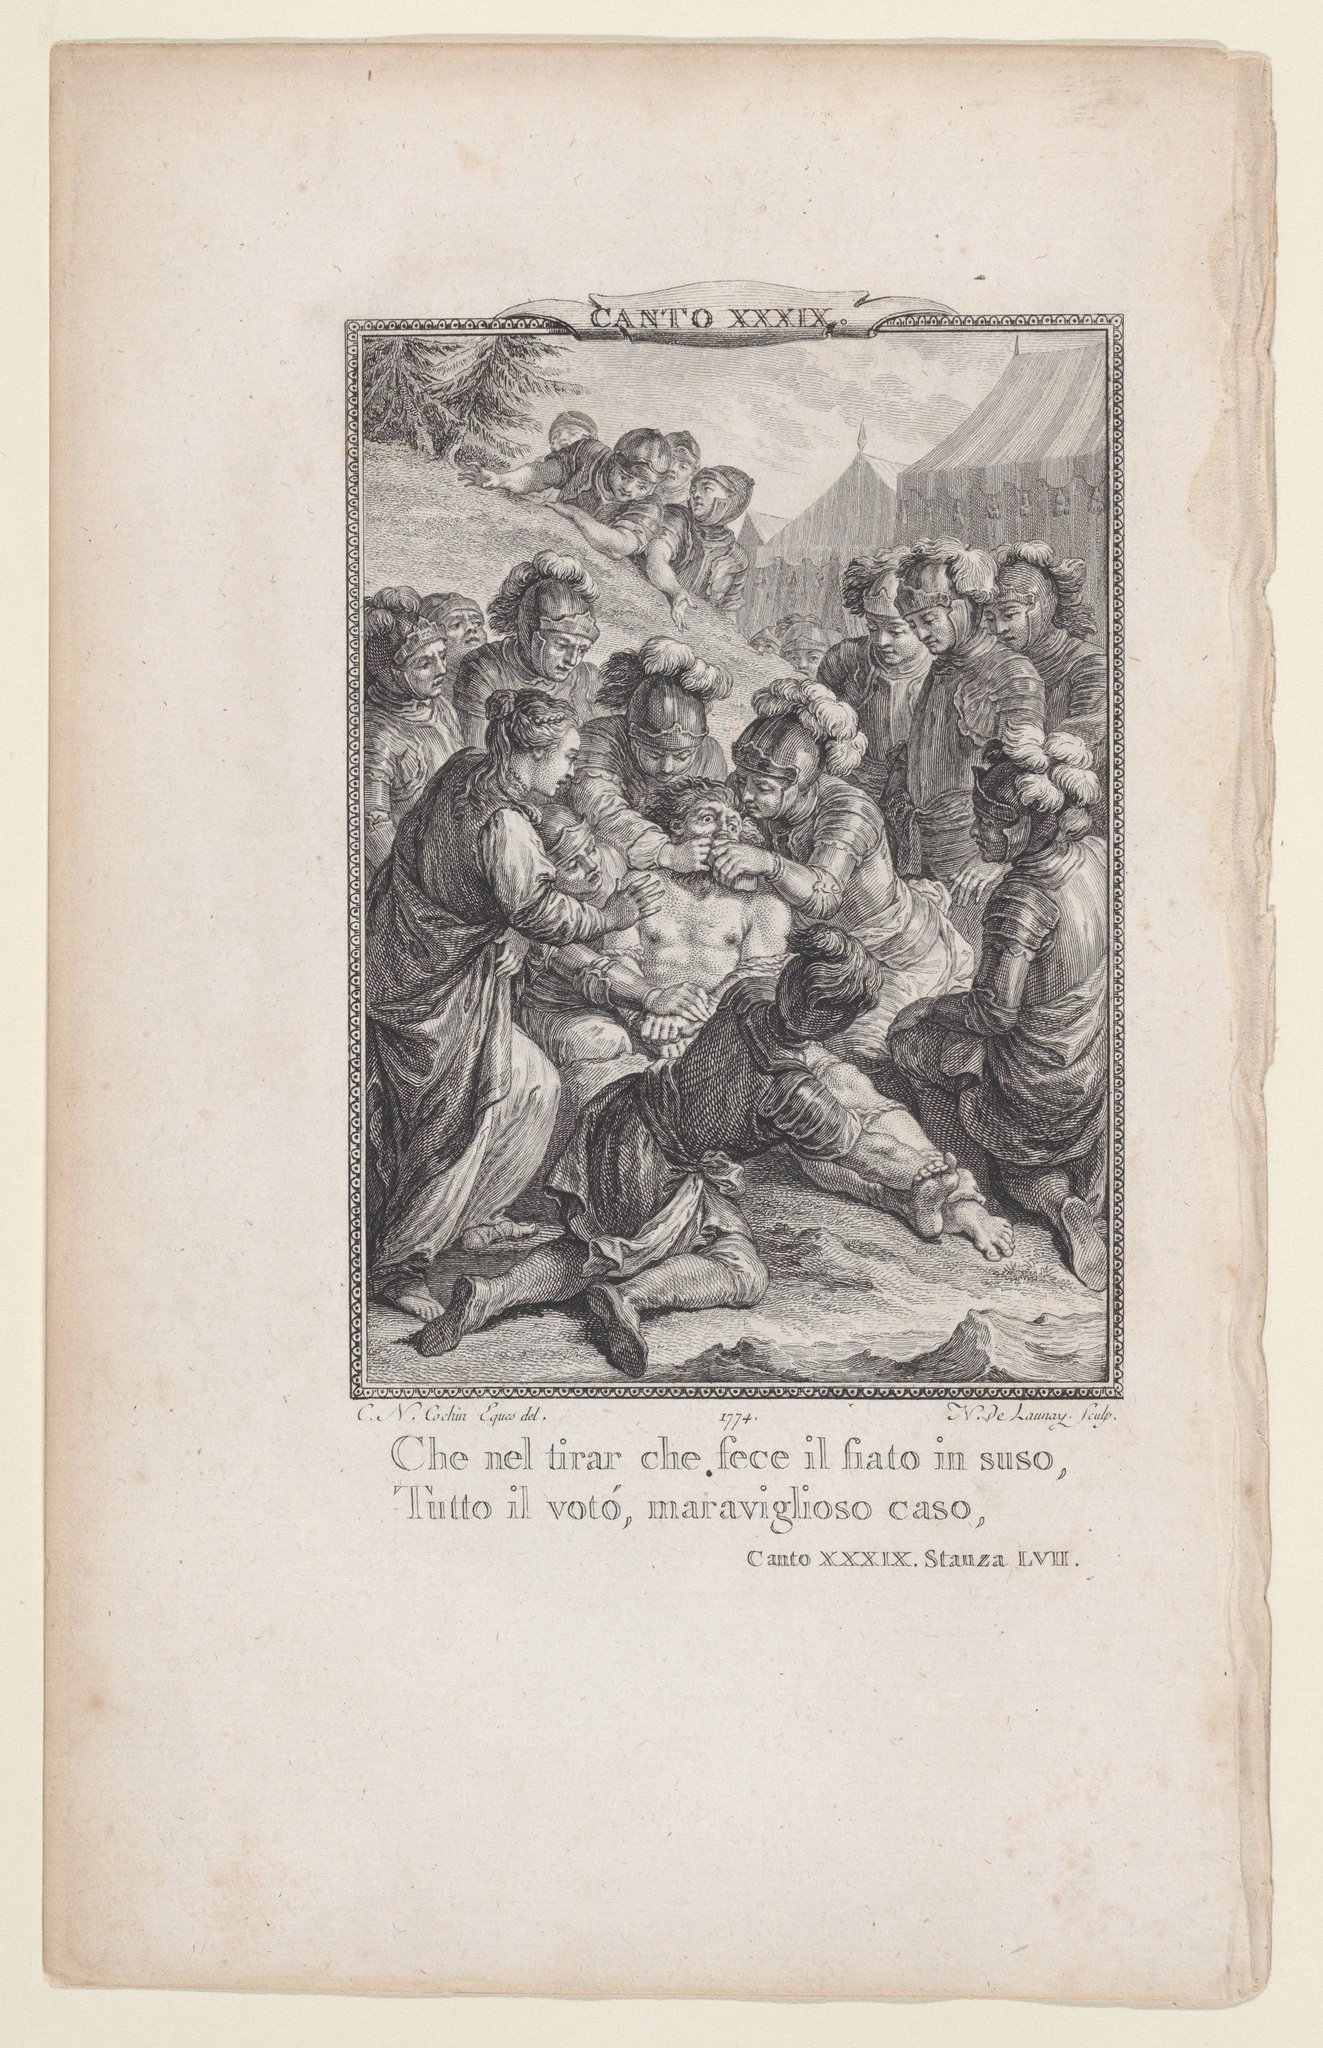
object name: print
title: Canto 39, Stanza 57, from "Orlando Furioso"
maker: nicolas de launay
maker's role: artist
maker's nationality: french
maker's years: 1739-1792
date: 1774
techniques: engraving, etching